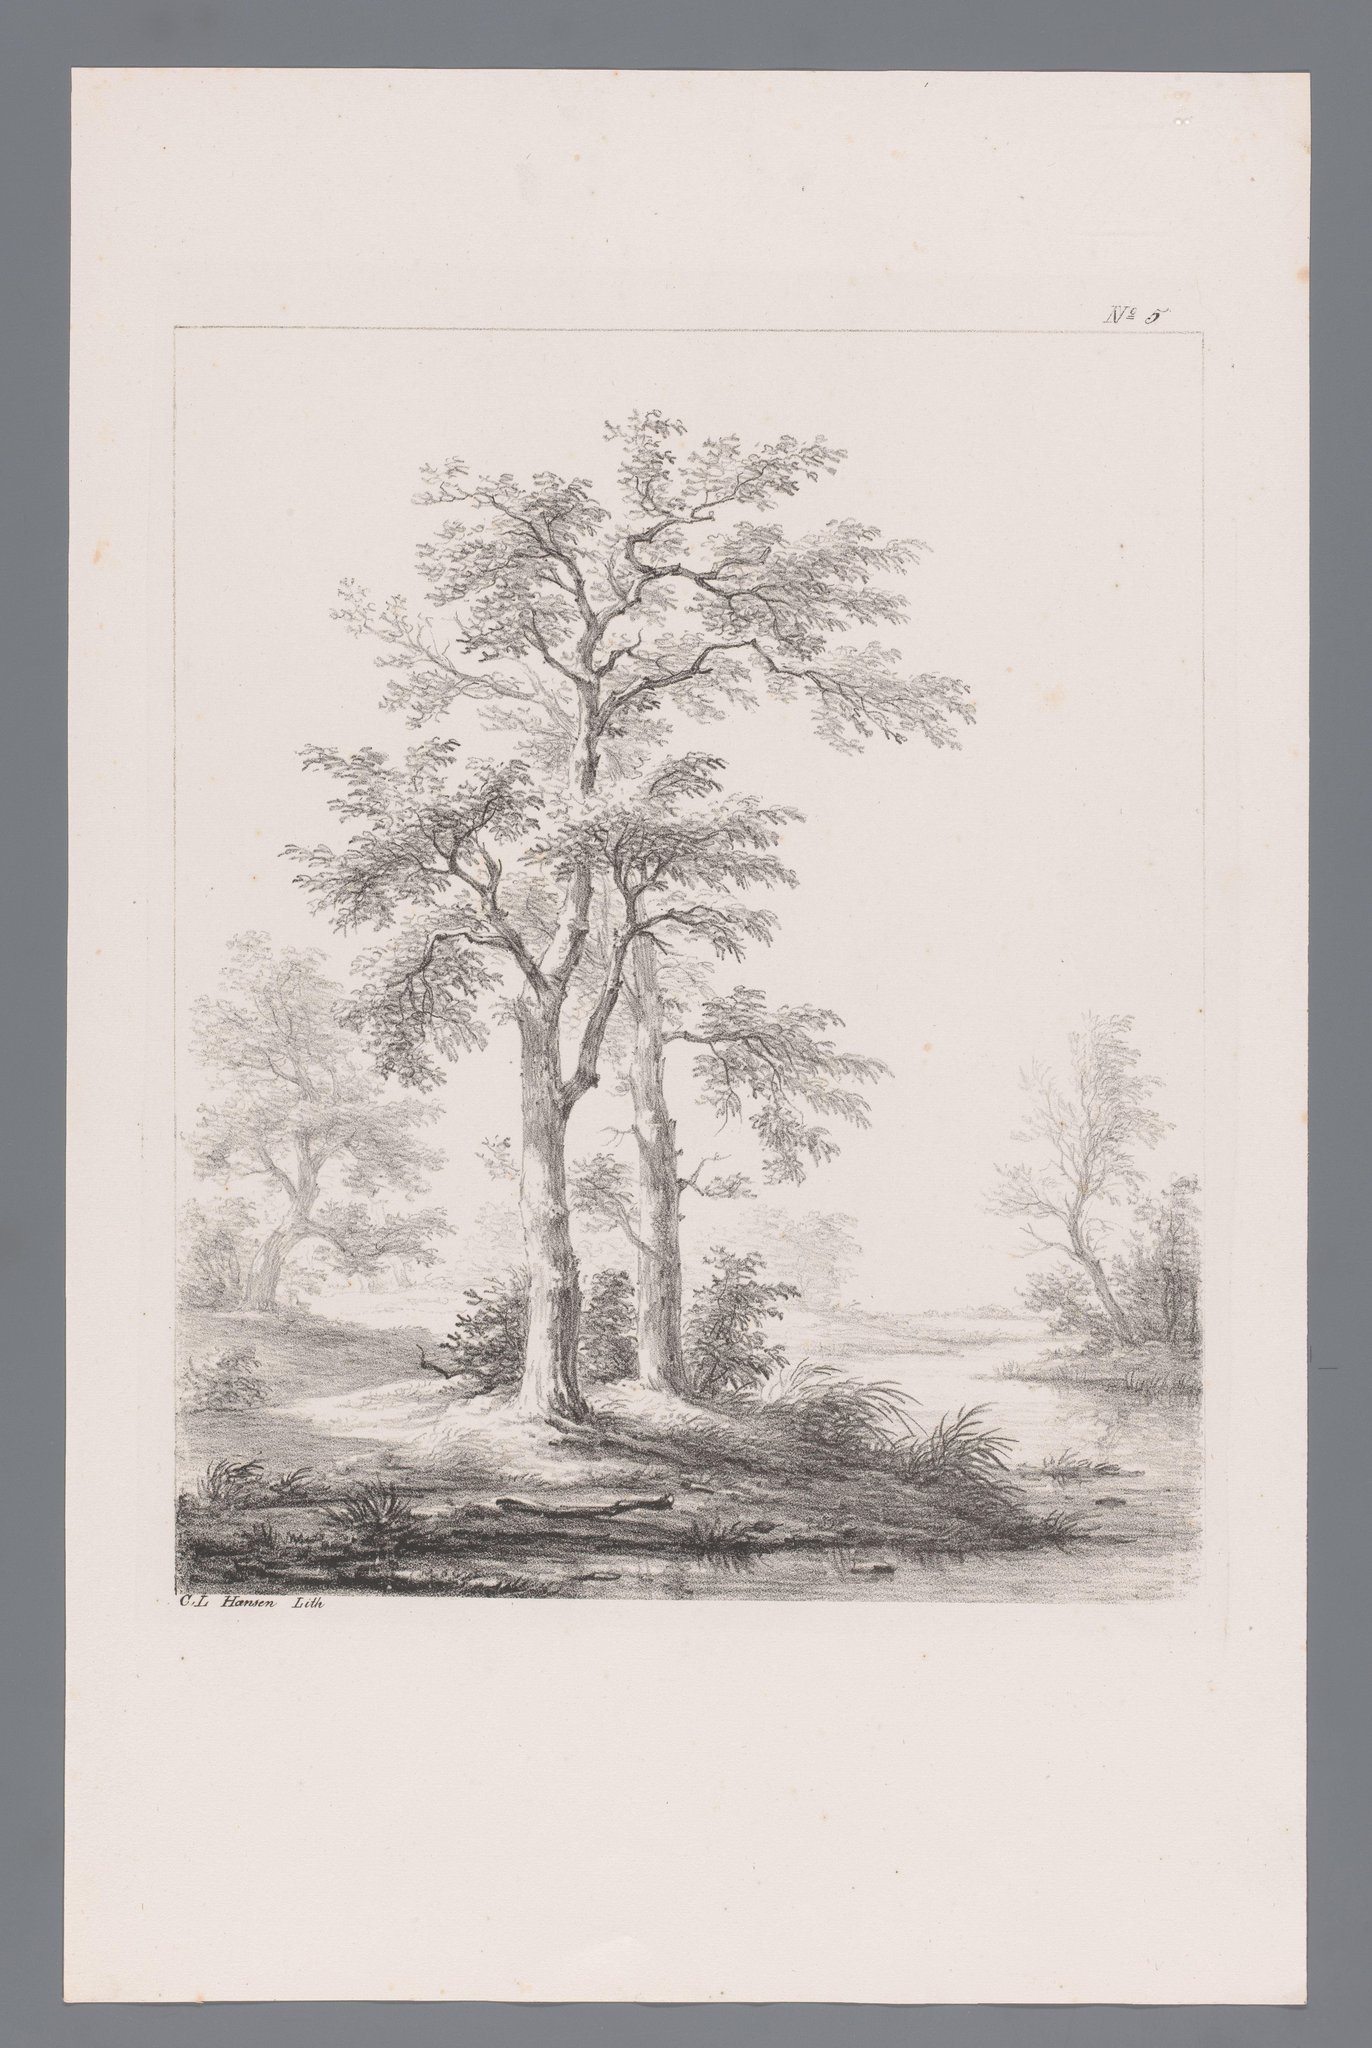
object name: print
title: Twee bomen bij een rivier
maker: carel lodewijk hansen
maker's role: draughtsman, painter, print maker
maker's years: 1765-1840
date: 1809-1840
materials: paper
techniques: lithograph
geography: netherlands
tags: river, landscapes with waters, waterscapes, seascapes (in the temperate zone), groups of trees